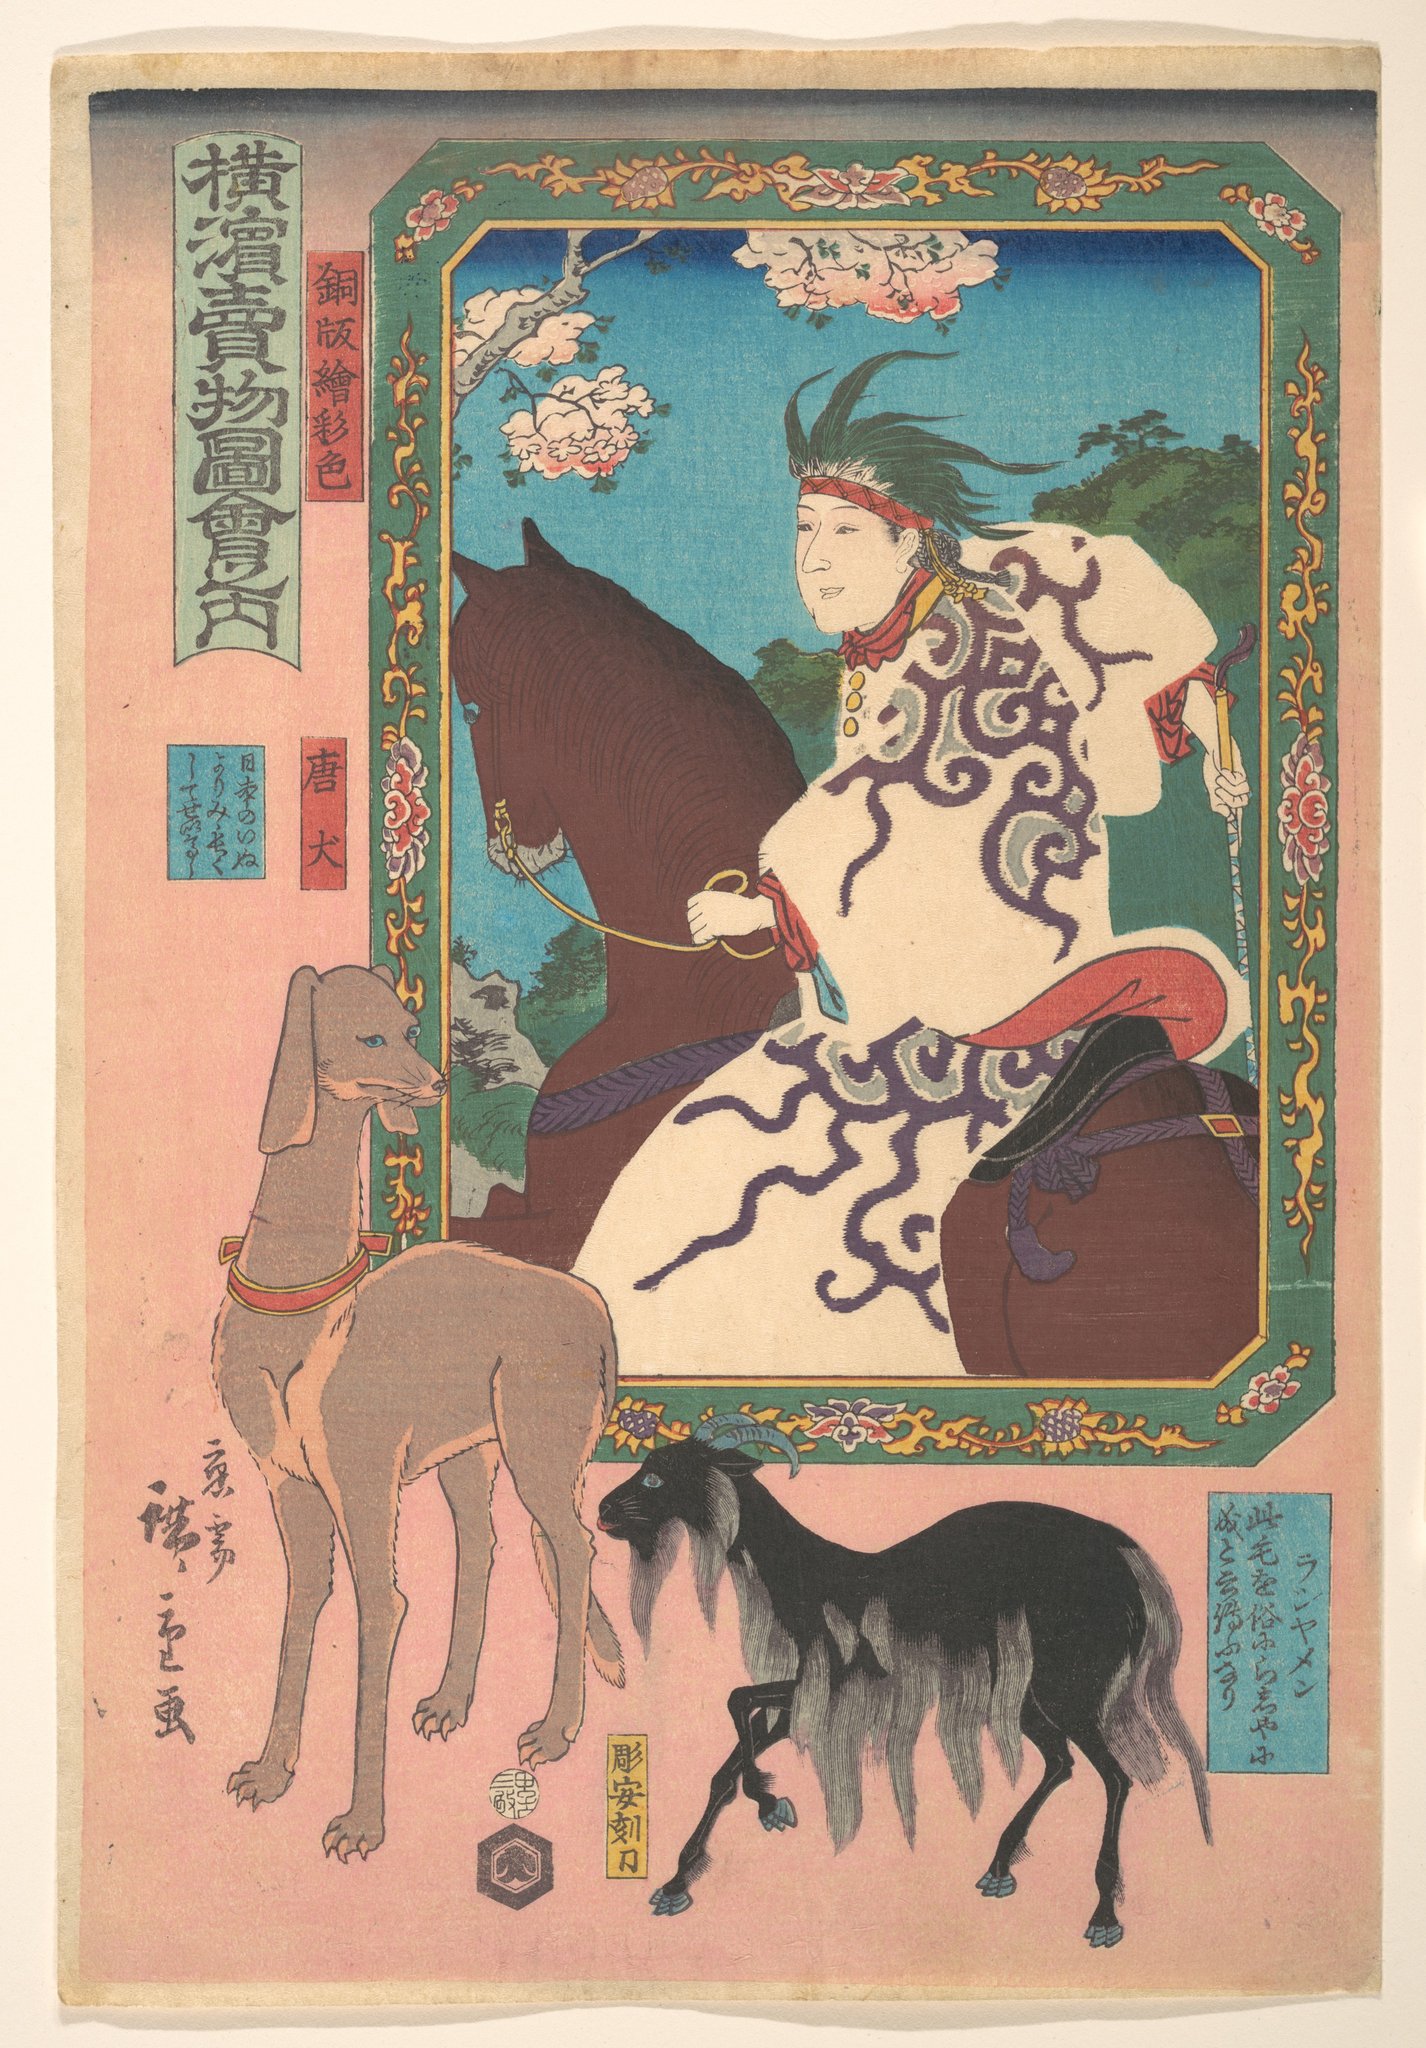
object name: woodblock print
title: Copper Plate Engraving of a Woman Riding a Horse, a Goat and a Dog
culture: japanese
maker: utagawa hiroshige ii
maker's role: artist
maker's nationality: japanese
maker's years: 1826-1869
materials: ink, paper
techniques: woodblock print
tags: women,dogs,goats,horses,flowers